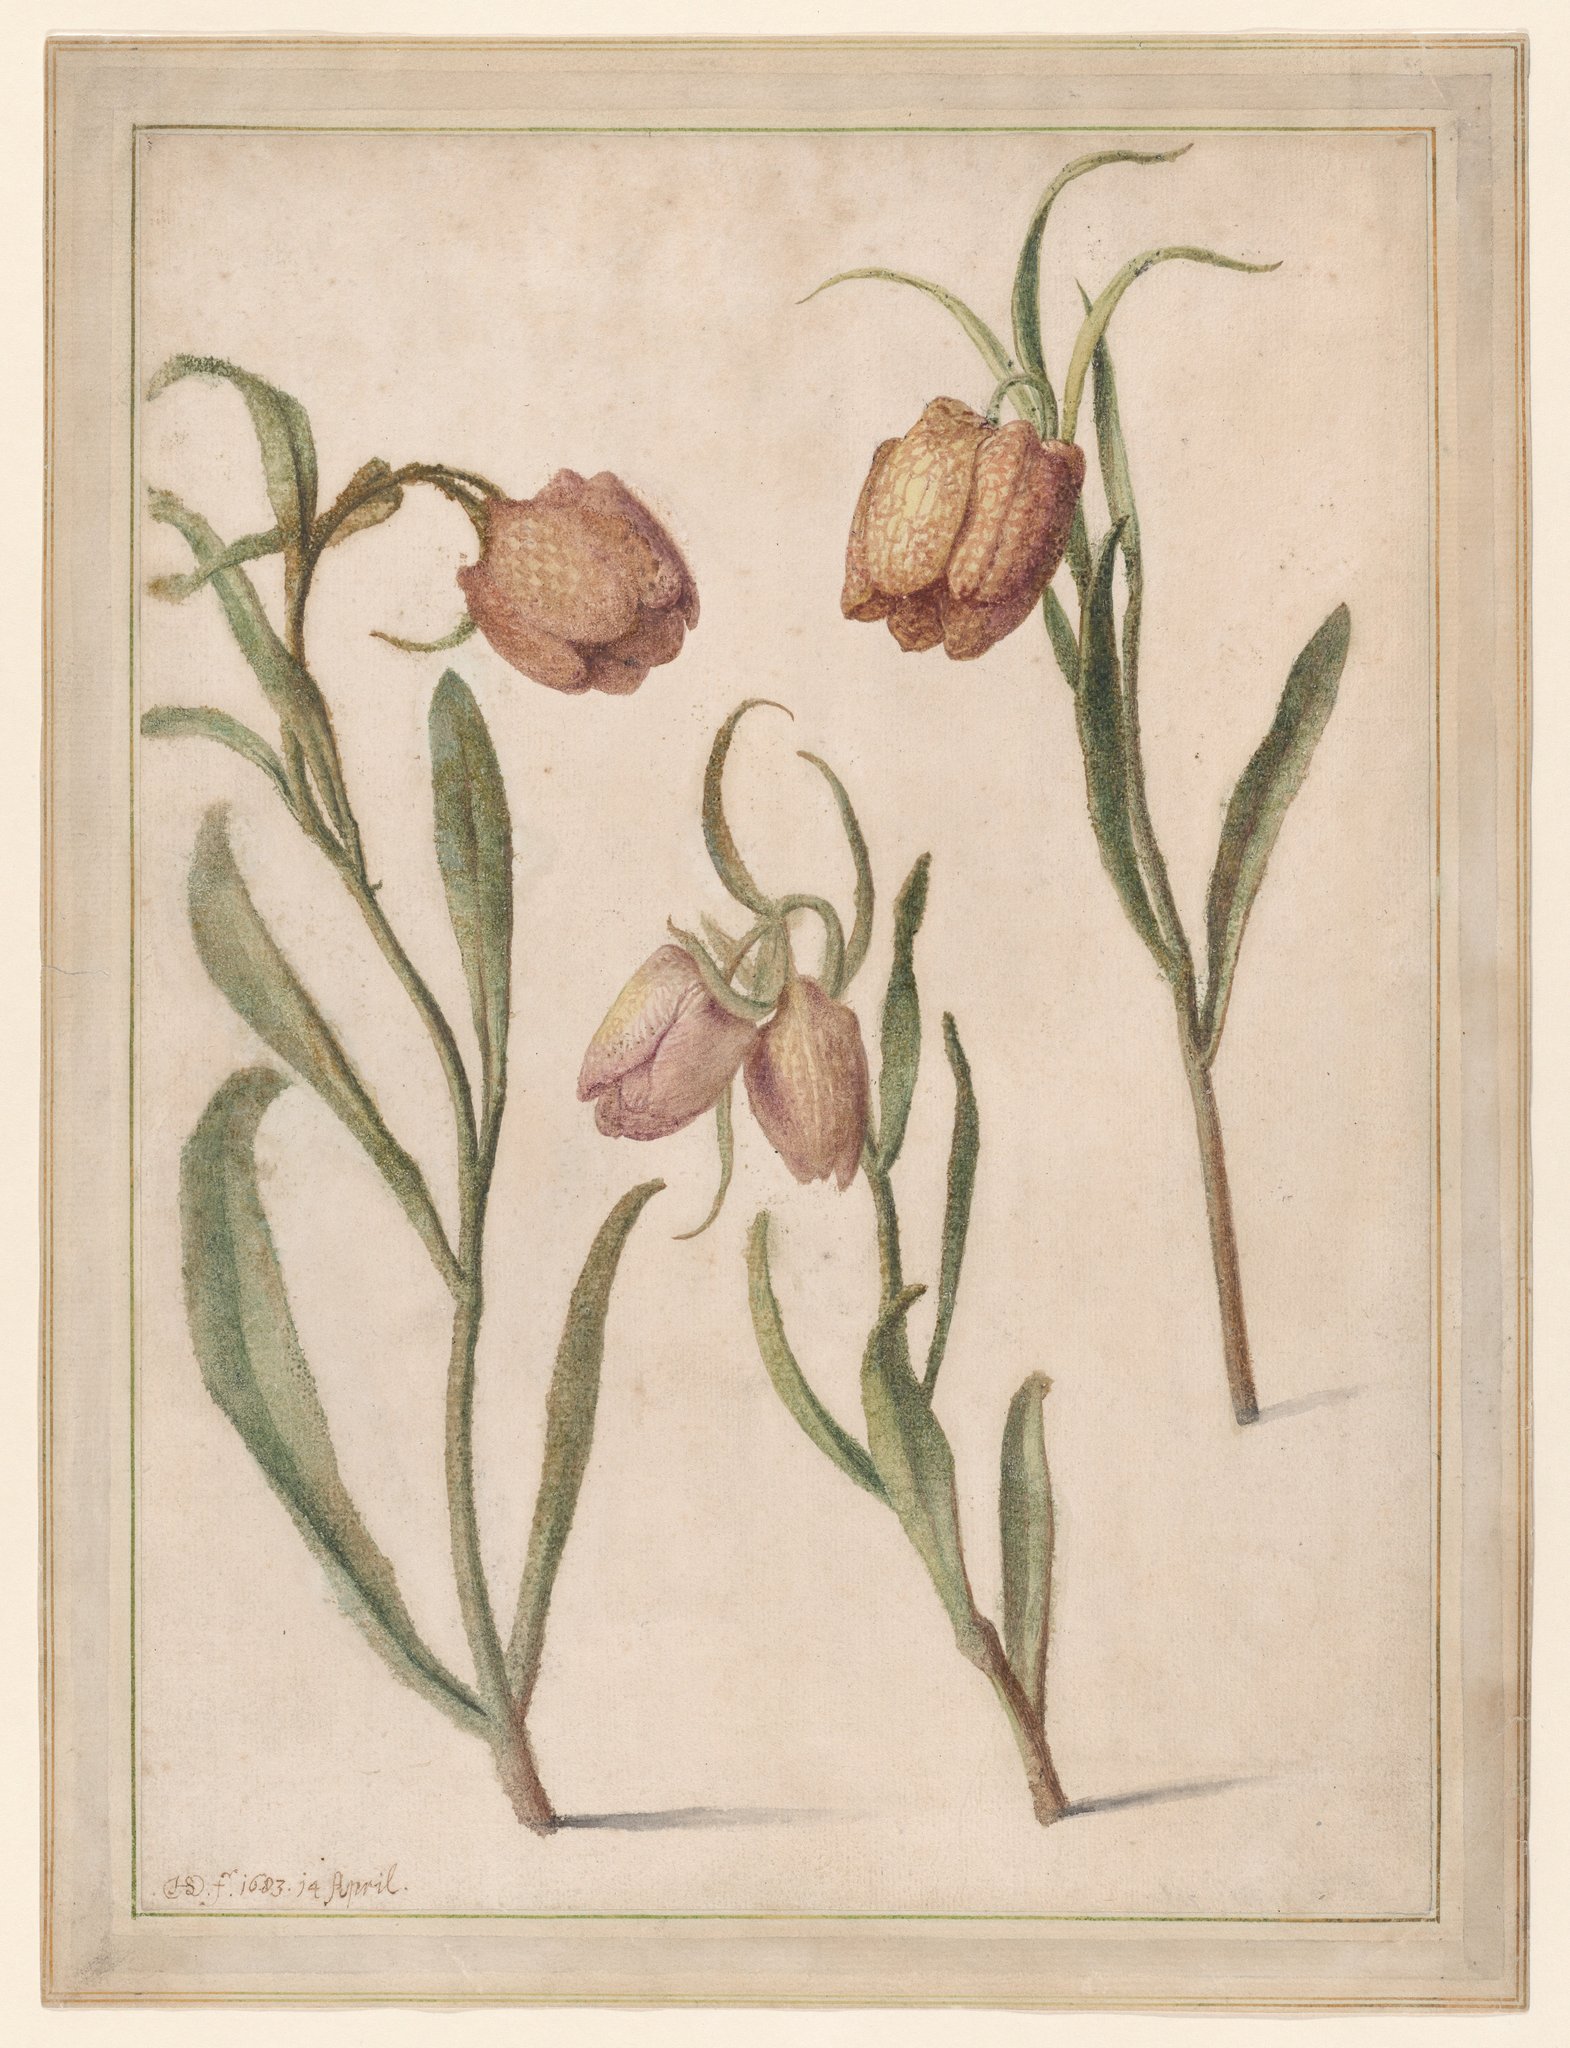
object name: drawing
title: Study of Three Fritillaries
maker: herman saftleven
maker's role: artist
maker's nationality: dutch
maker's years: 1609-1685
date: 1683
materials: watercolor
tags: flowers